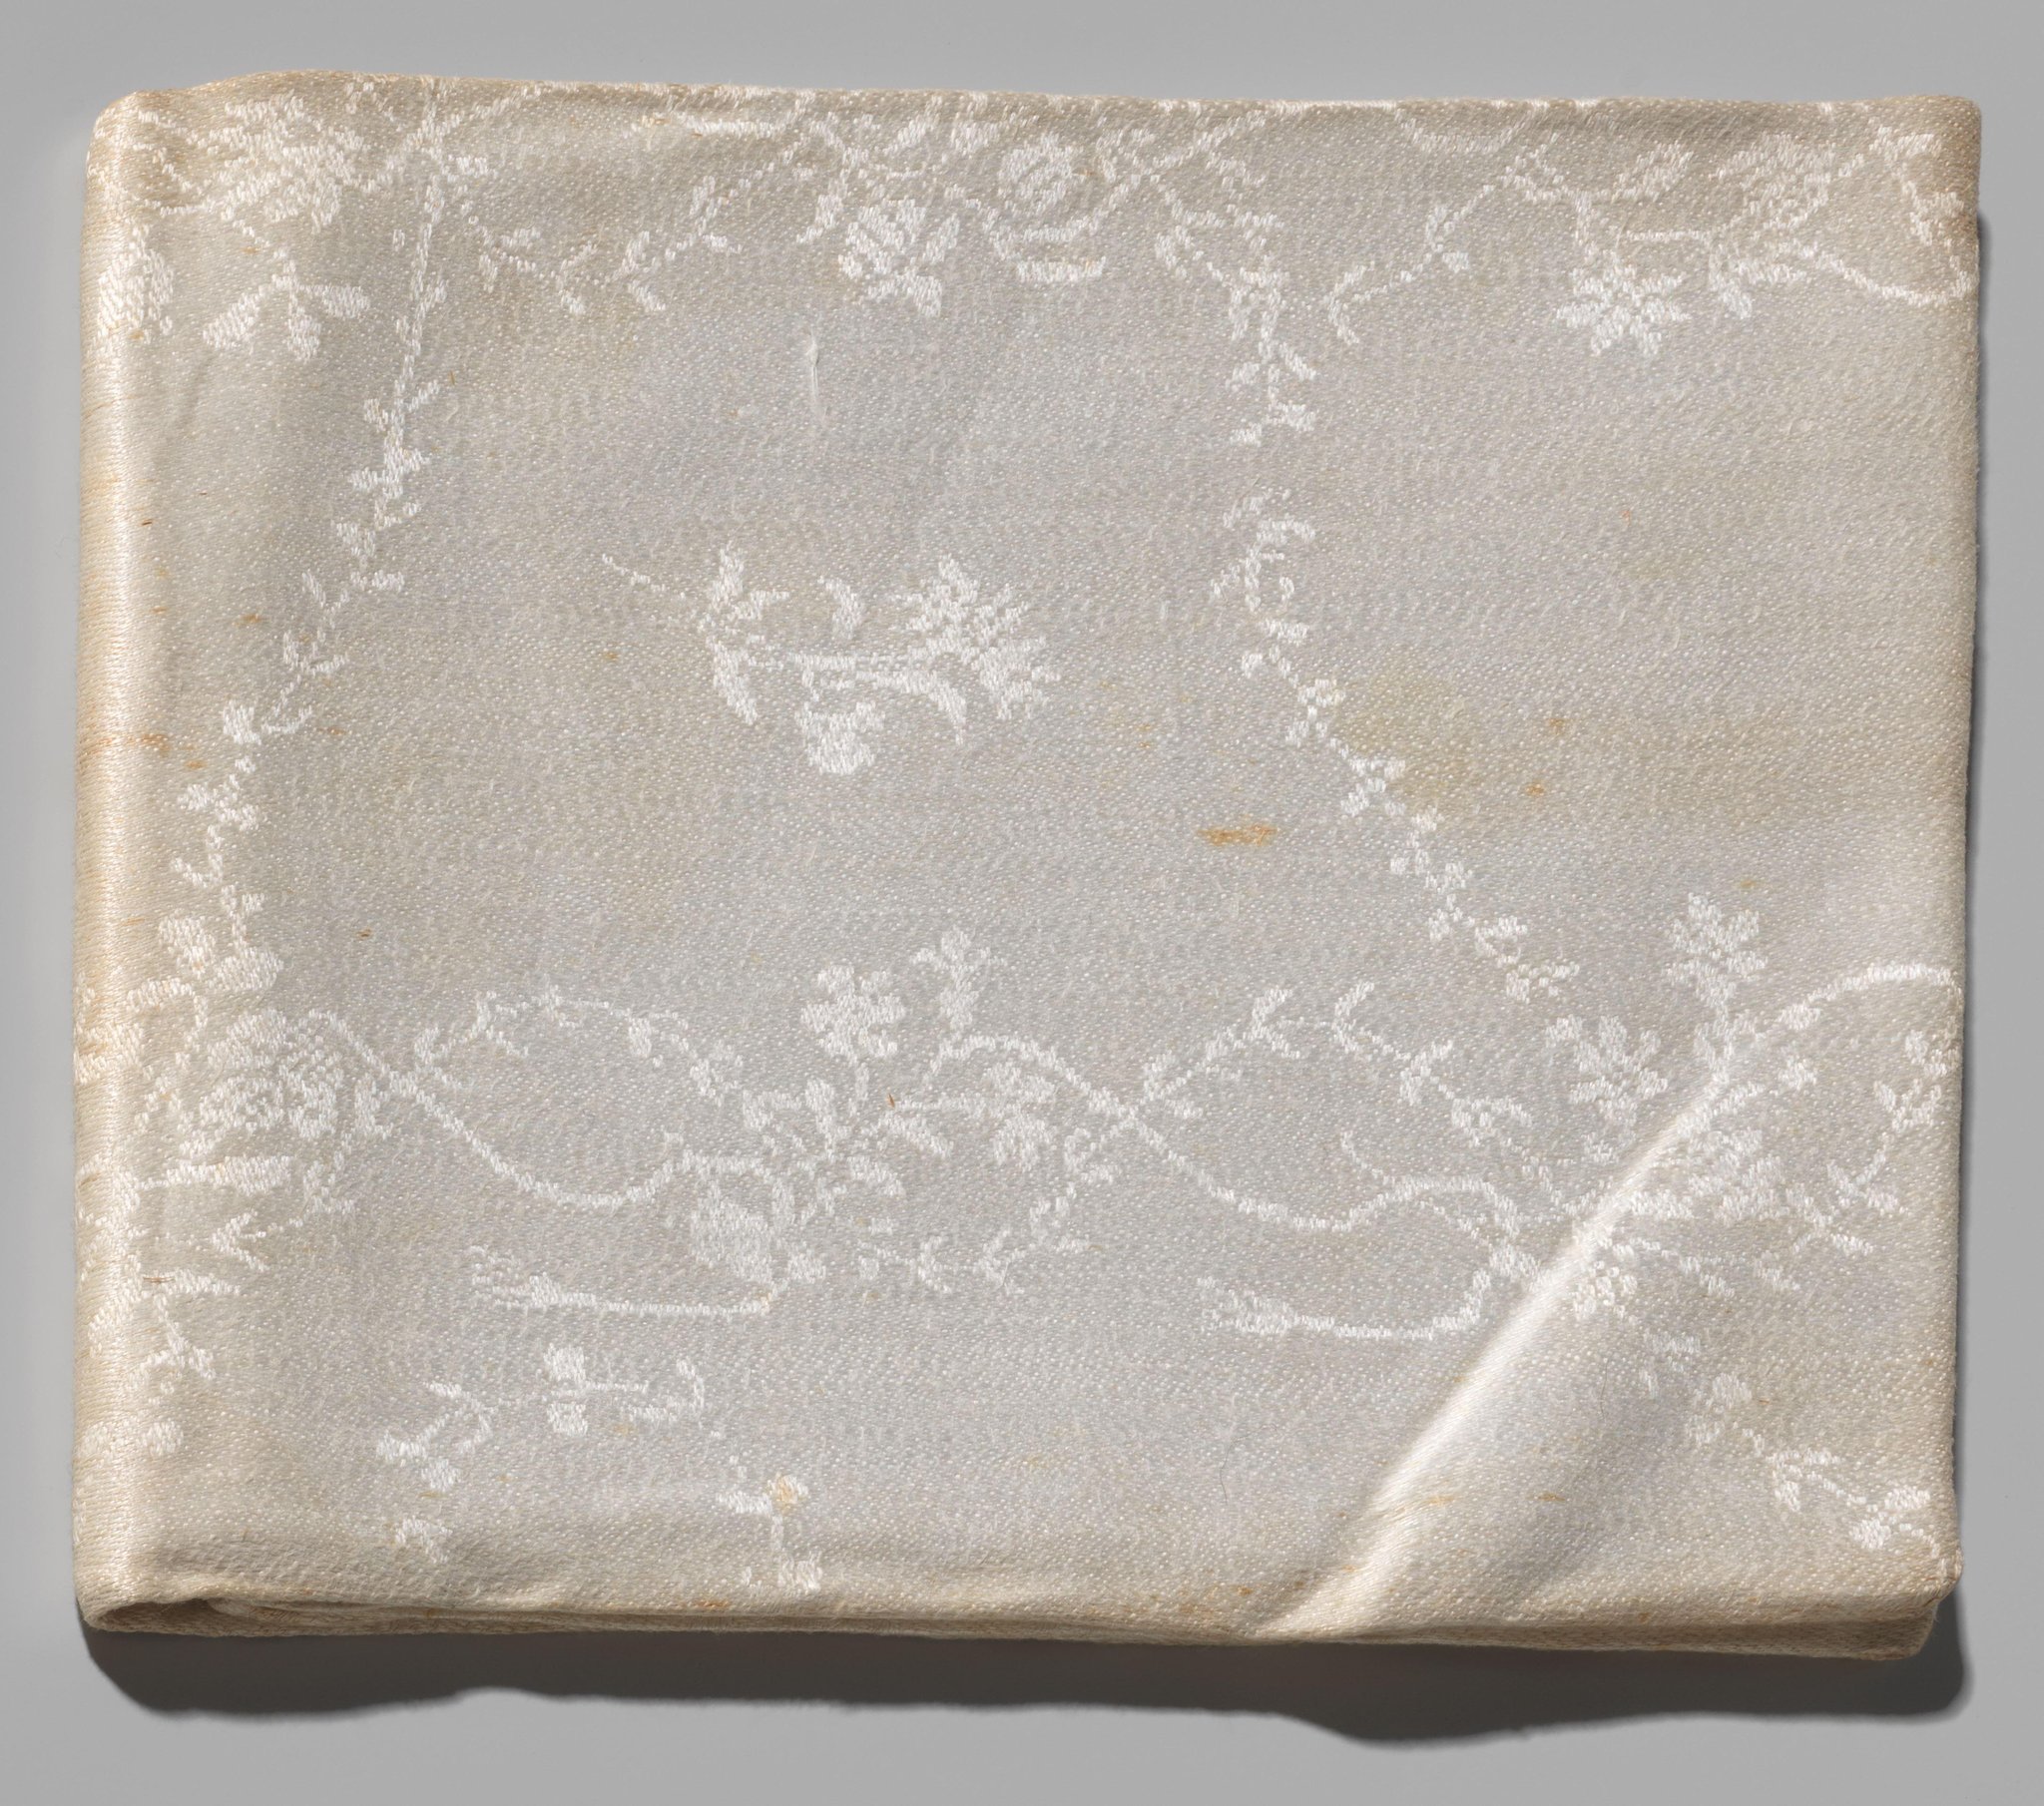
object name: napkin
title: Servet met bloemen en slingers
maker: Anonymous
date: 1800-1810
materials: linen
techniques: damask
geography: brabant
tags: ewout van der hoog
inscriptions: mark: ‘IVDH 24’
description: Servet van linnendamast met bloemen en slingers. Middenveld: een rechtopgaande fijne slingerende tak, met koord en kwast gebonden, wordt door een breed golvende bebladerde tak doorsneden. Randen: driemaal een rechte lijst, spiraalsgewijs omwonden; de middelste is breed en met bladeren omwonden, de buitenste smal en met een fijne bloementak omrankt.